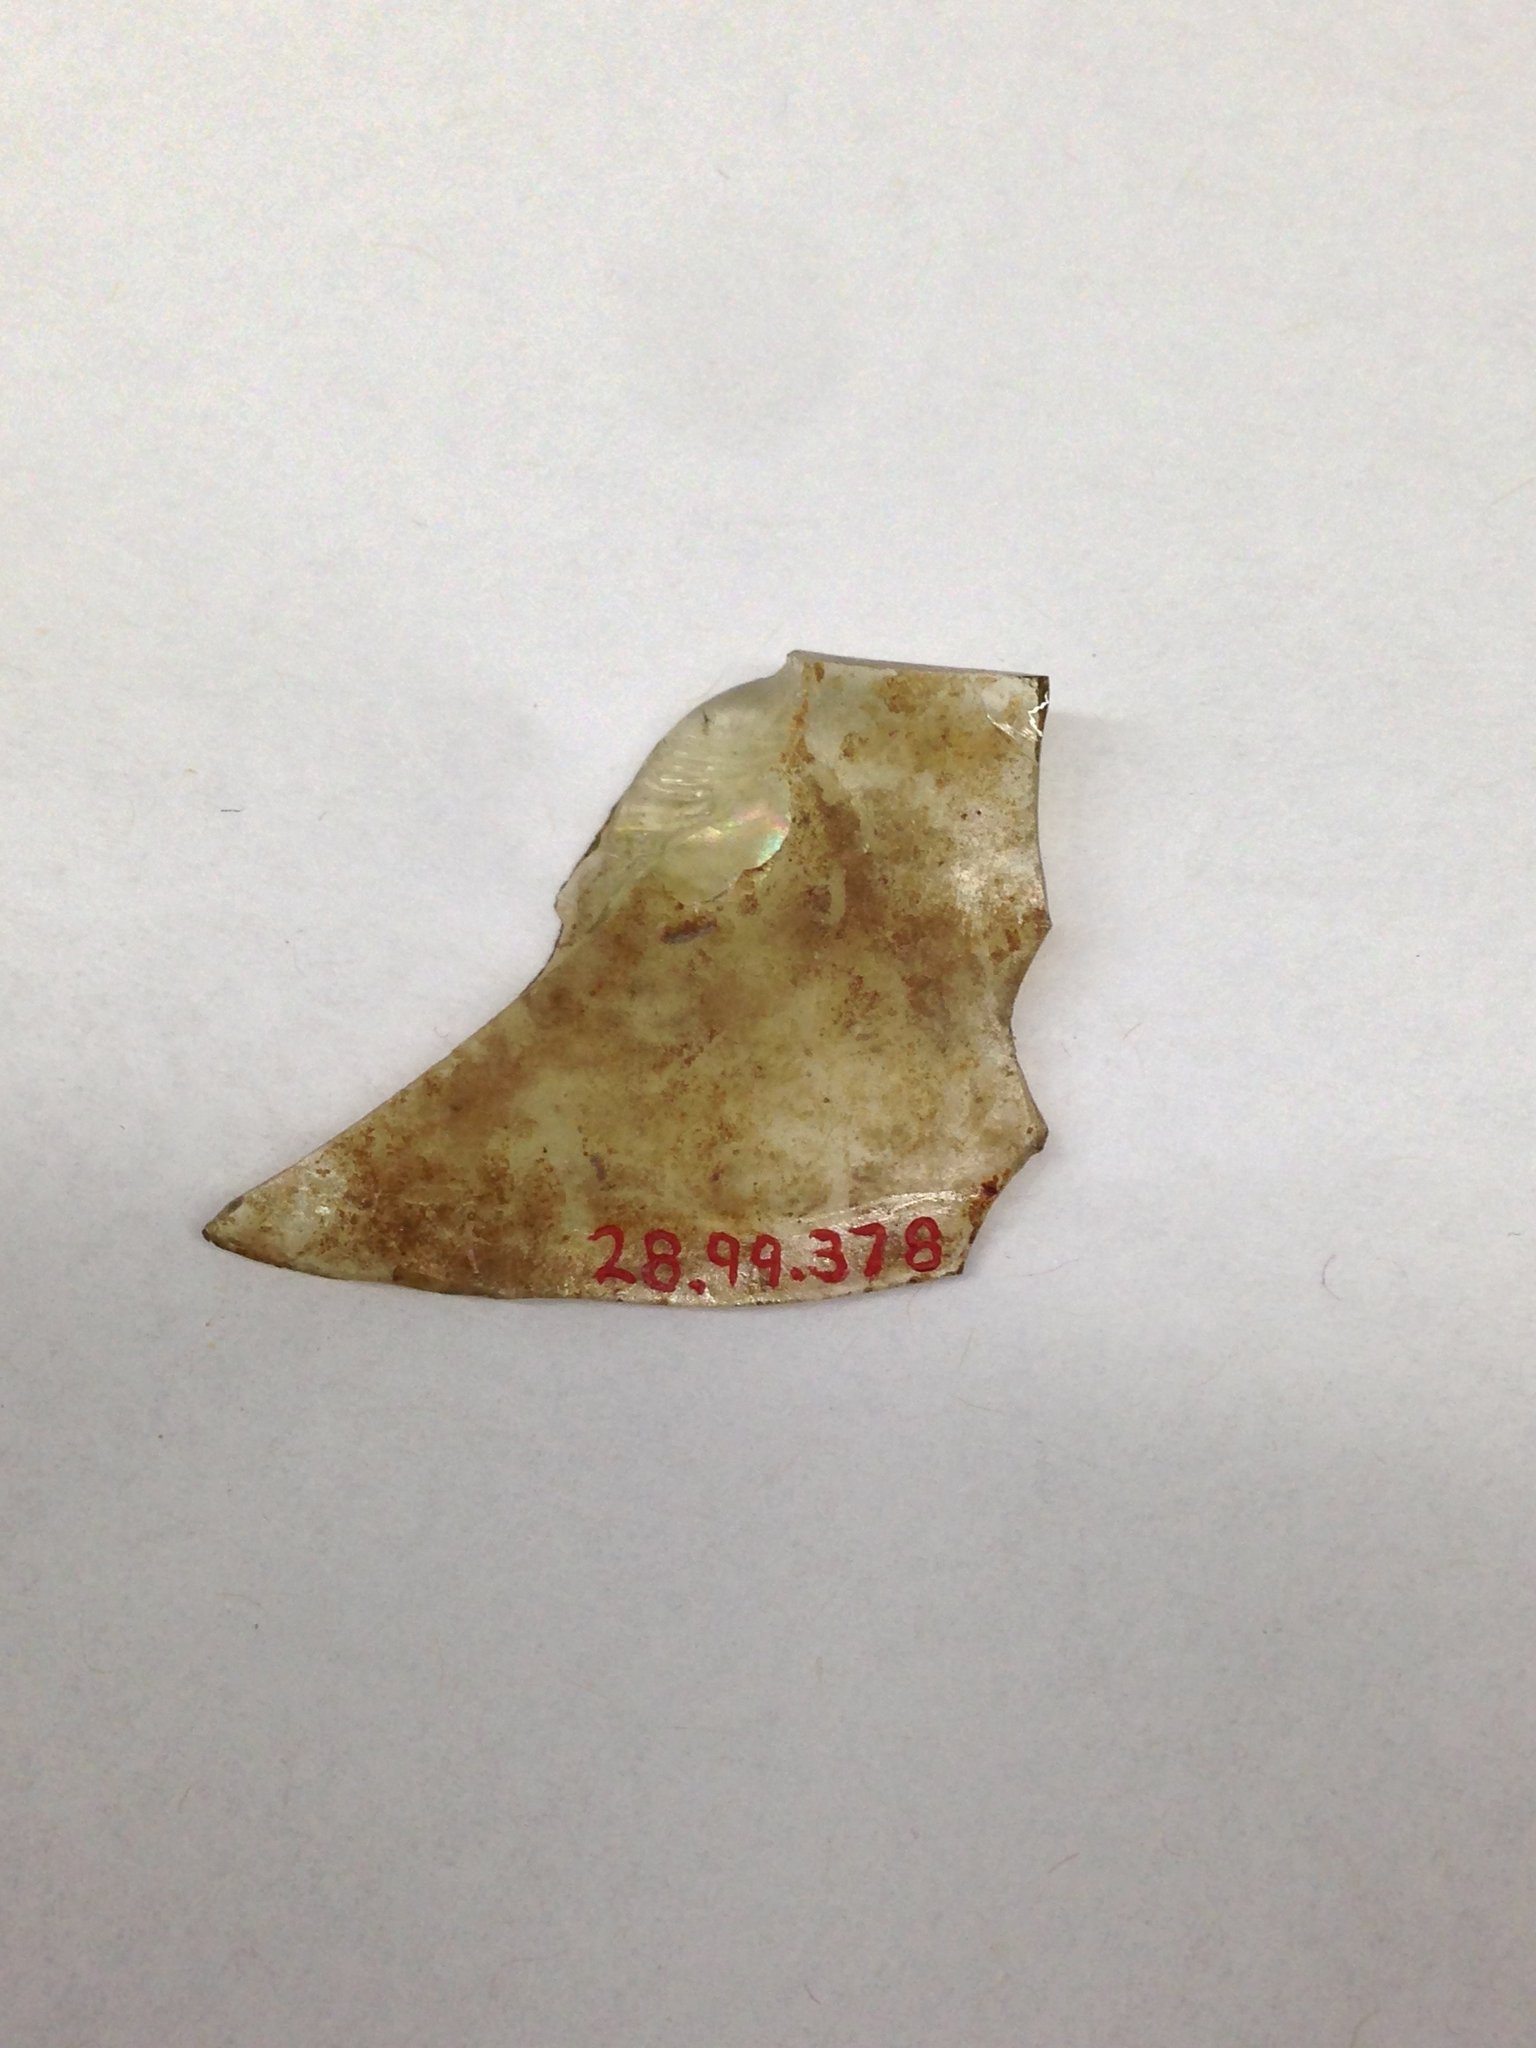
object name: fragment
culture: european or middle eastern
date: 1150-1250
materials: ceramic, glass